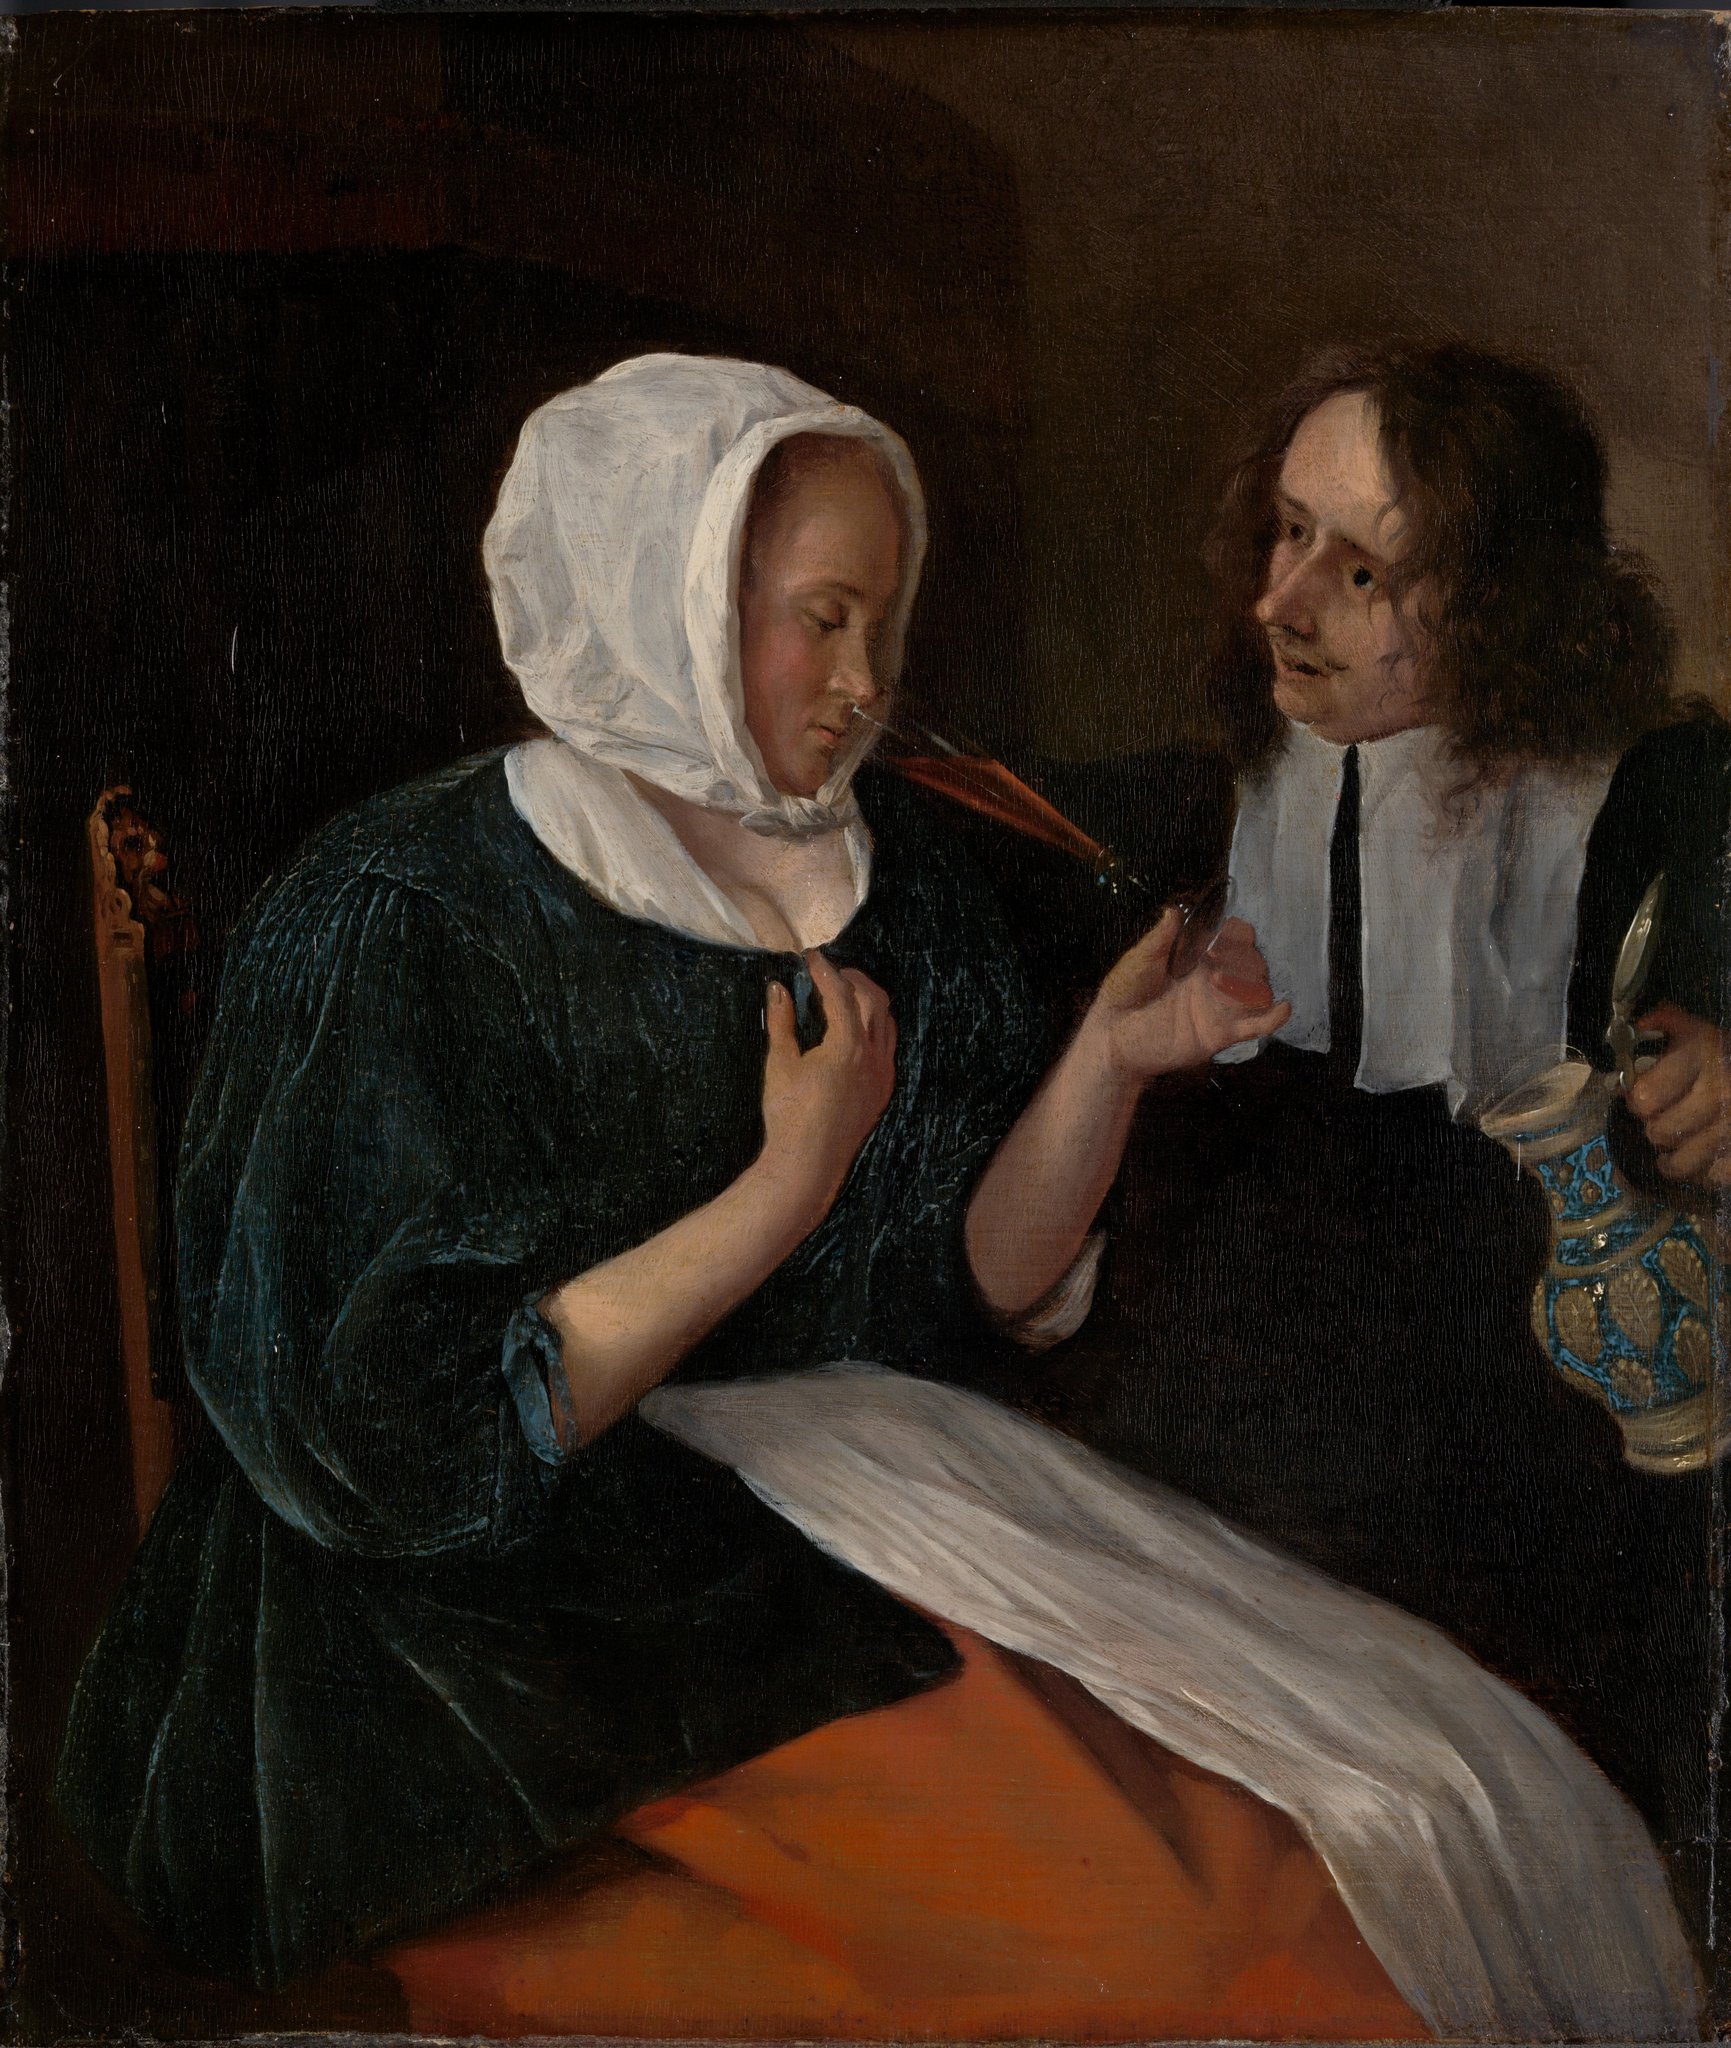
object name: painting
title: A couple drinking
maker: jan havicksz. steen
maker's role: painter, print maker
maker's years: 1625-1679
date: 1660-1679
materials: oil, panel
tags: glass of wine, courting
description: Een drinkend paar. Een zittende jonge vrouw met een witte hoofddoek neemt een slok uit een fluitglas. Rechts een jonge man met een kruik wijn.